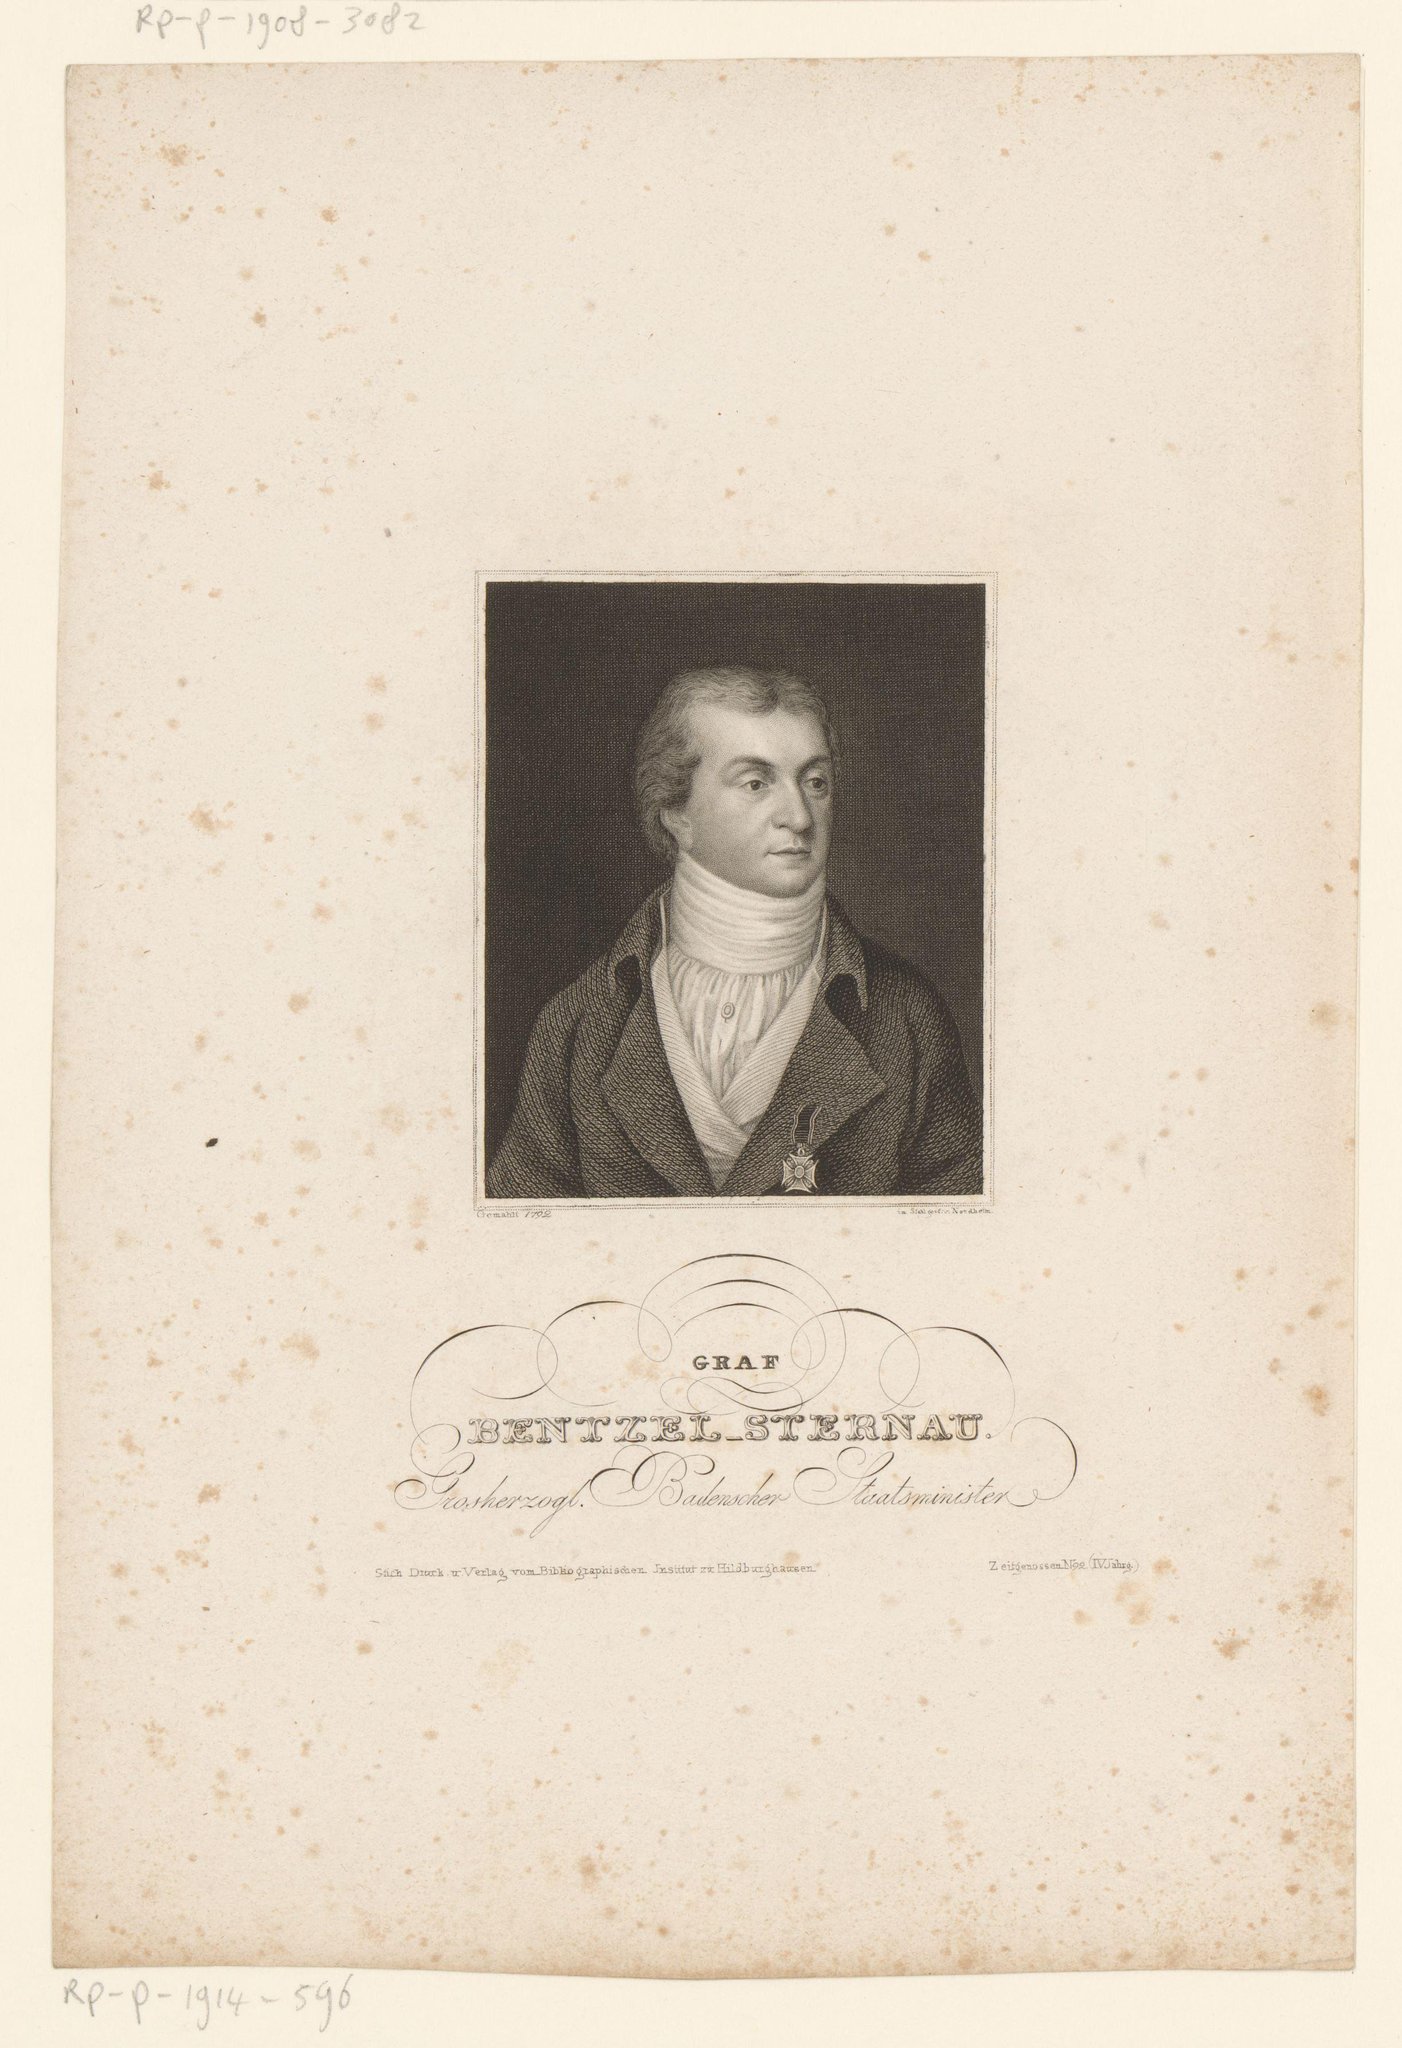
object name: print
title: Portret van Anselm Franz, Freiherr von Bentzel-Sternau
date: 1829-1840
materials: paper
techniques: engraving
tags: historical persons, medals and other marks of military honour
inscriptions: collector's mark: Lugt 2228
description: Afkomstig uit de portretserie 'Zeitgenossen', uitgegeven tussen 1829 en circa 1840.